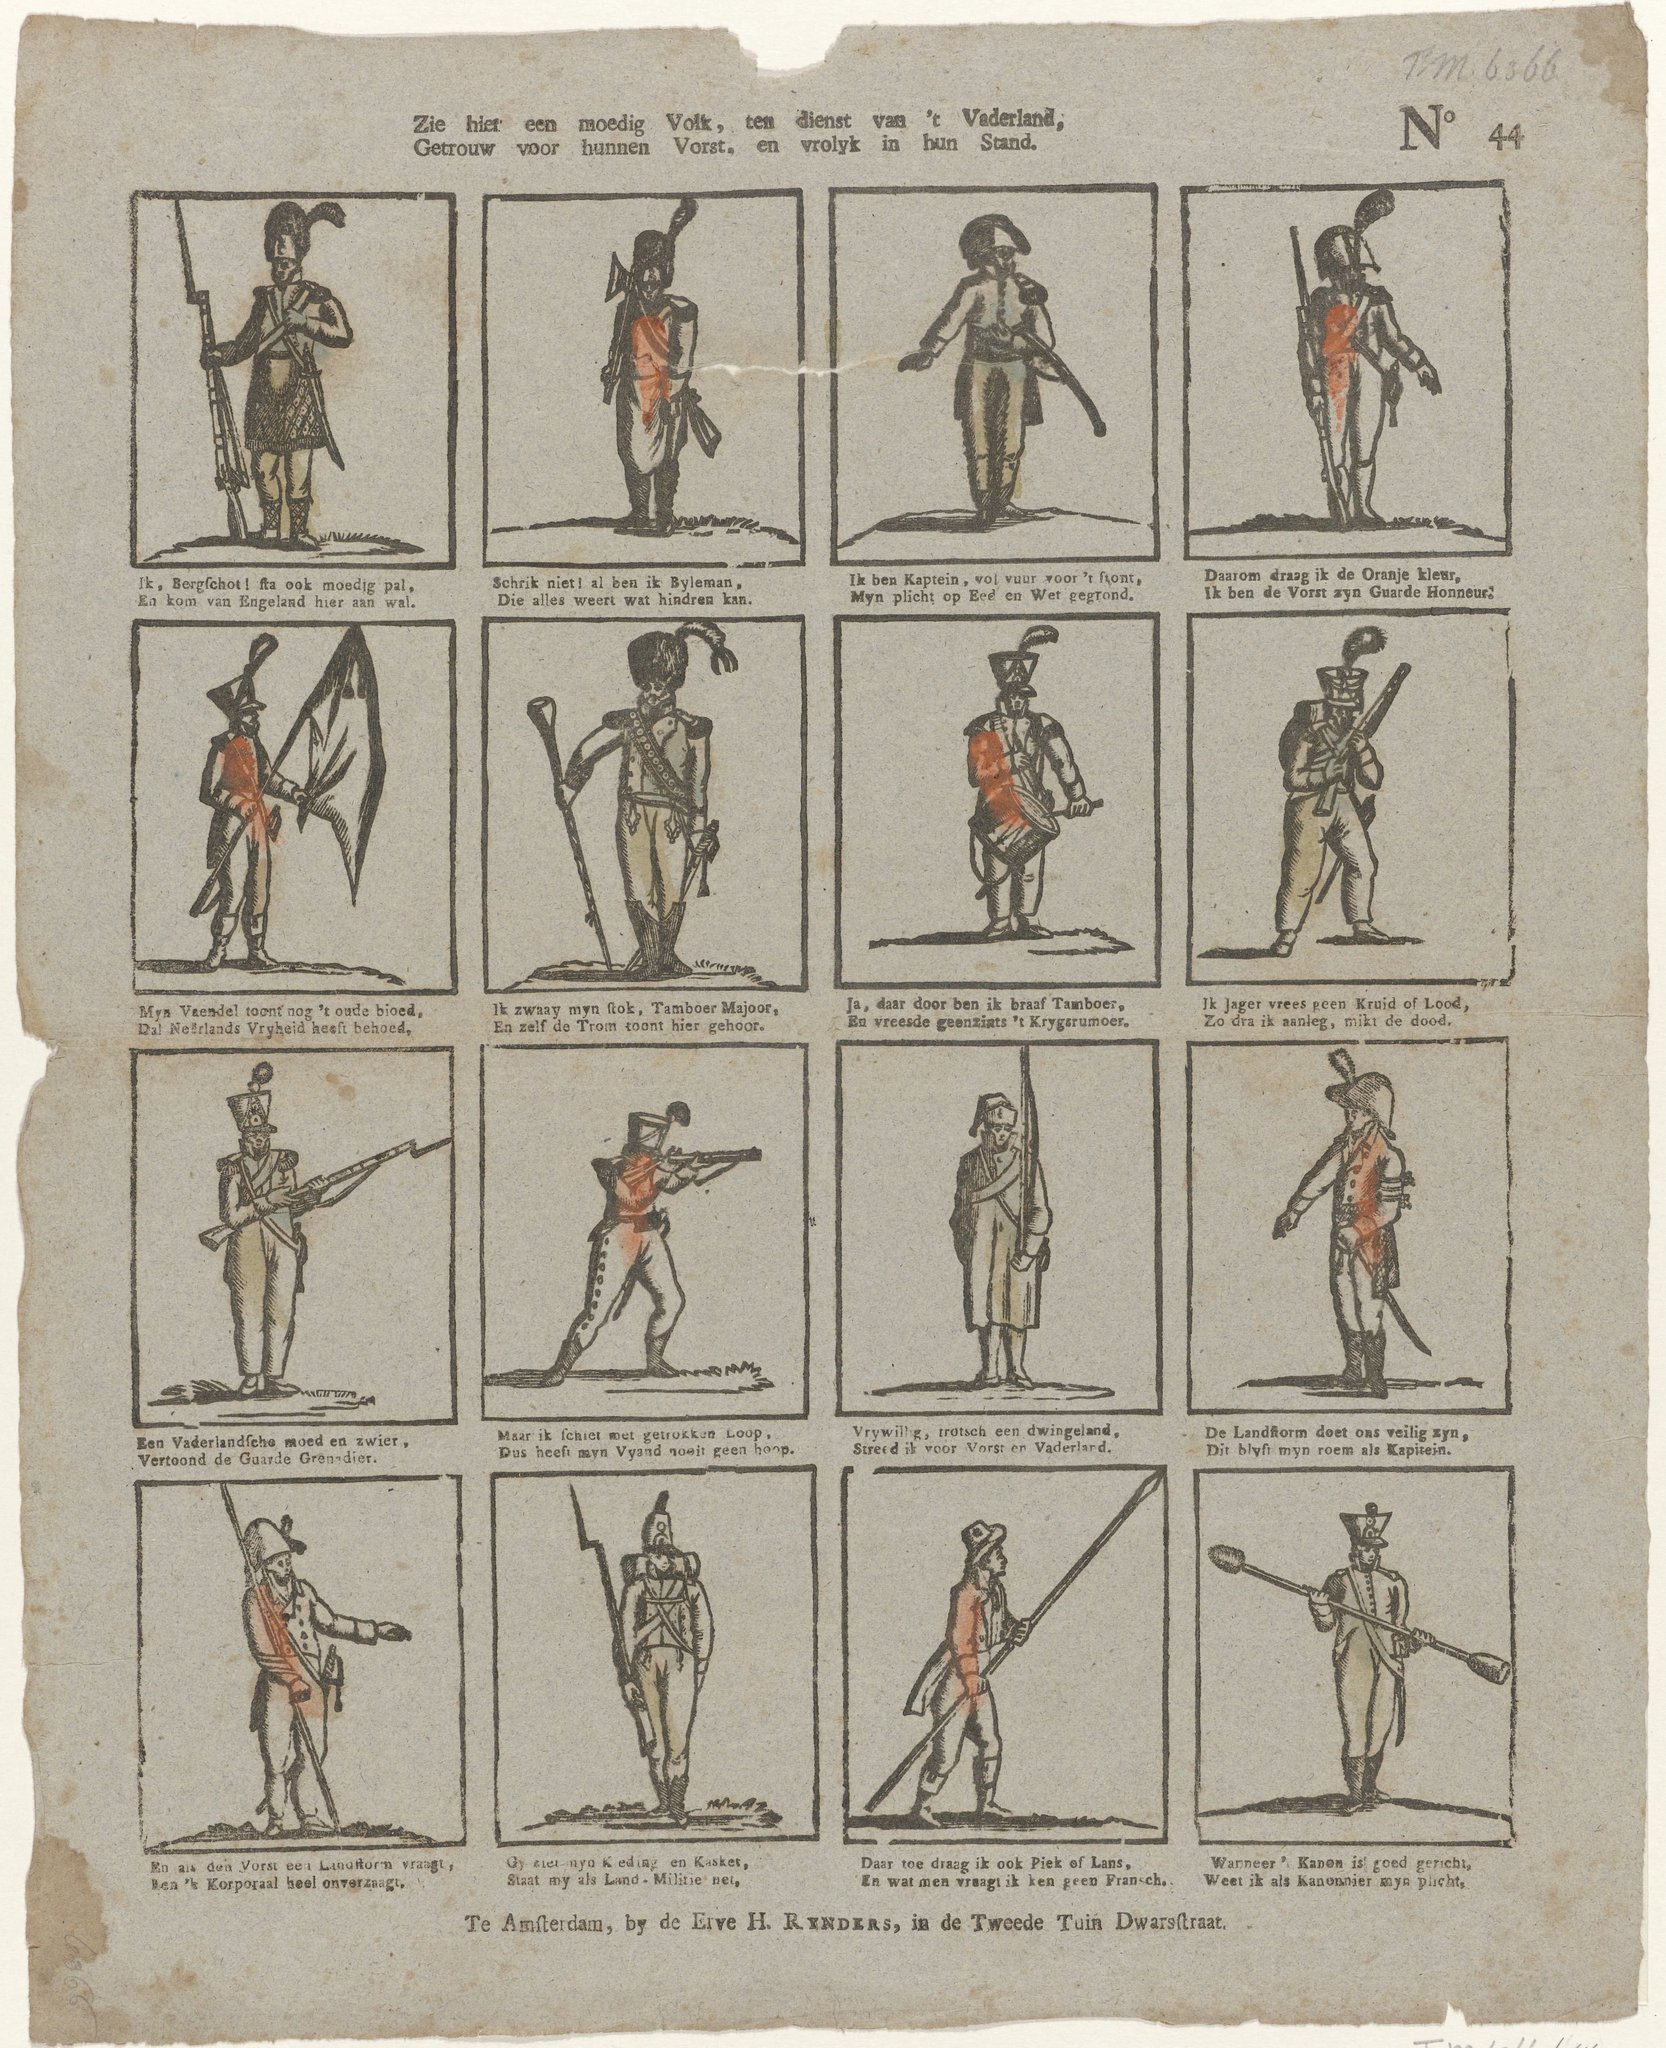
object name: popular print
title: Zie hier een moedig Volk, ten dienst van 't Vaderland (...)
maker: Anonymous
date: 1830-1855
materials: paper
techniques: colour, letterpress printing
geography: amsterdam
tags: warfare; military affairs (+ infantry)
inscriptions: collector's mark: Lugt 2228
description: Blad met zestien voorstellingen van militairen van verschillende rangen. Onder elk plaatje een tweeregelig versje. Genummerd rechtsboven: No. 44. Ca. 1830-1855.